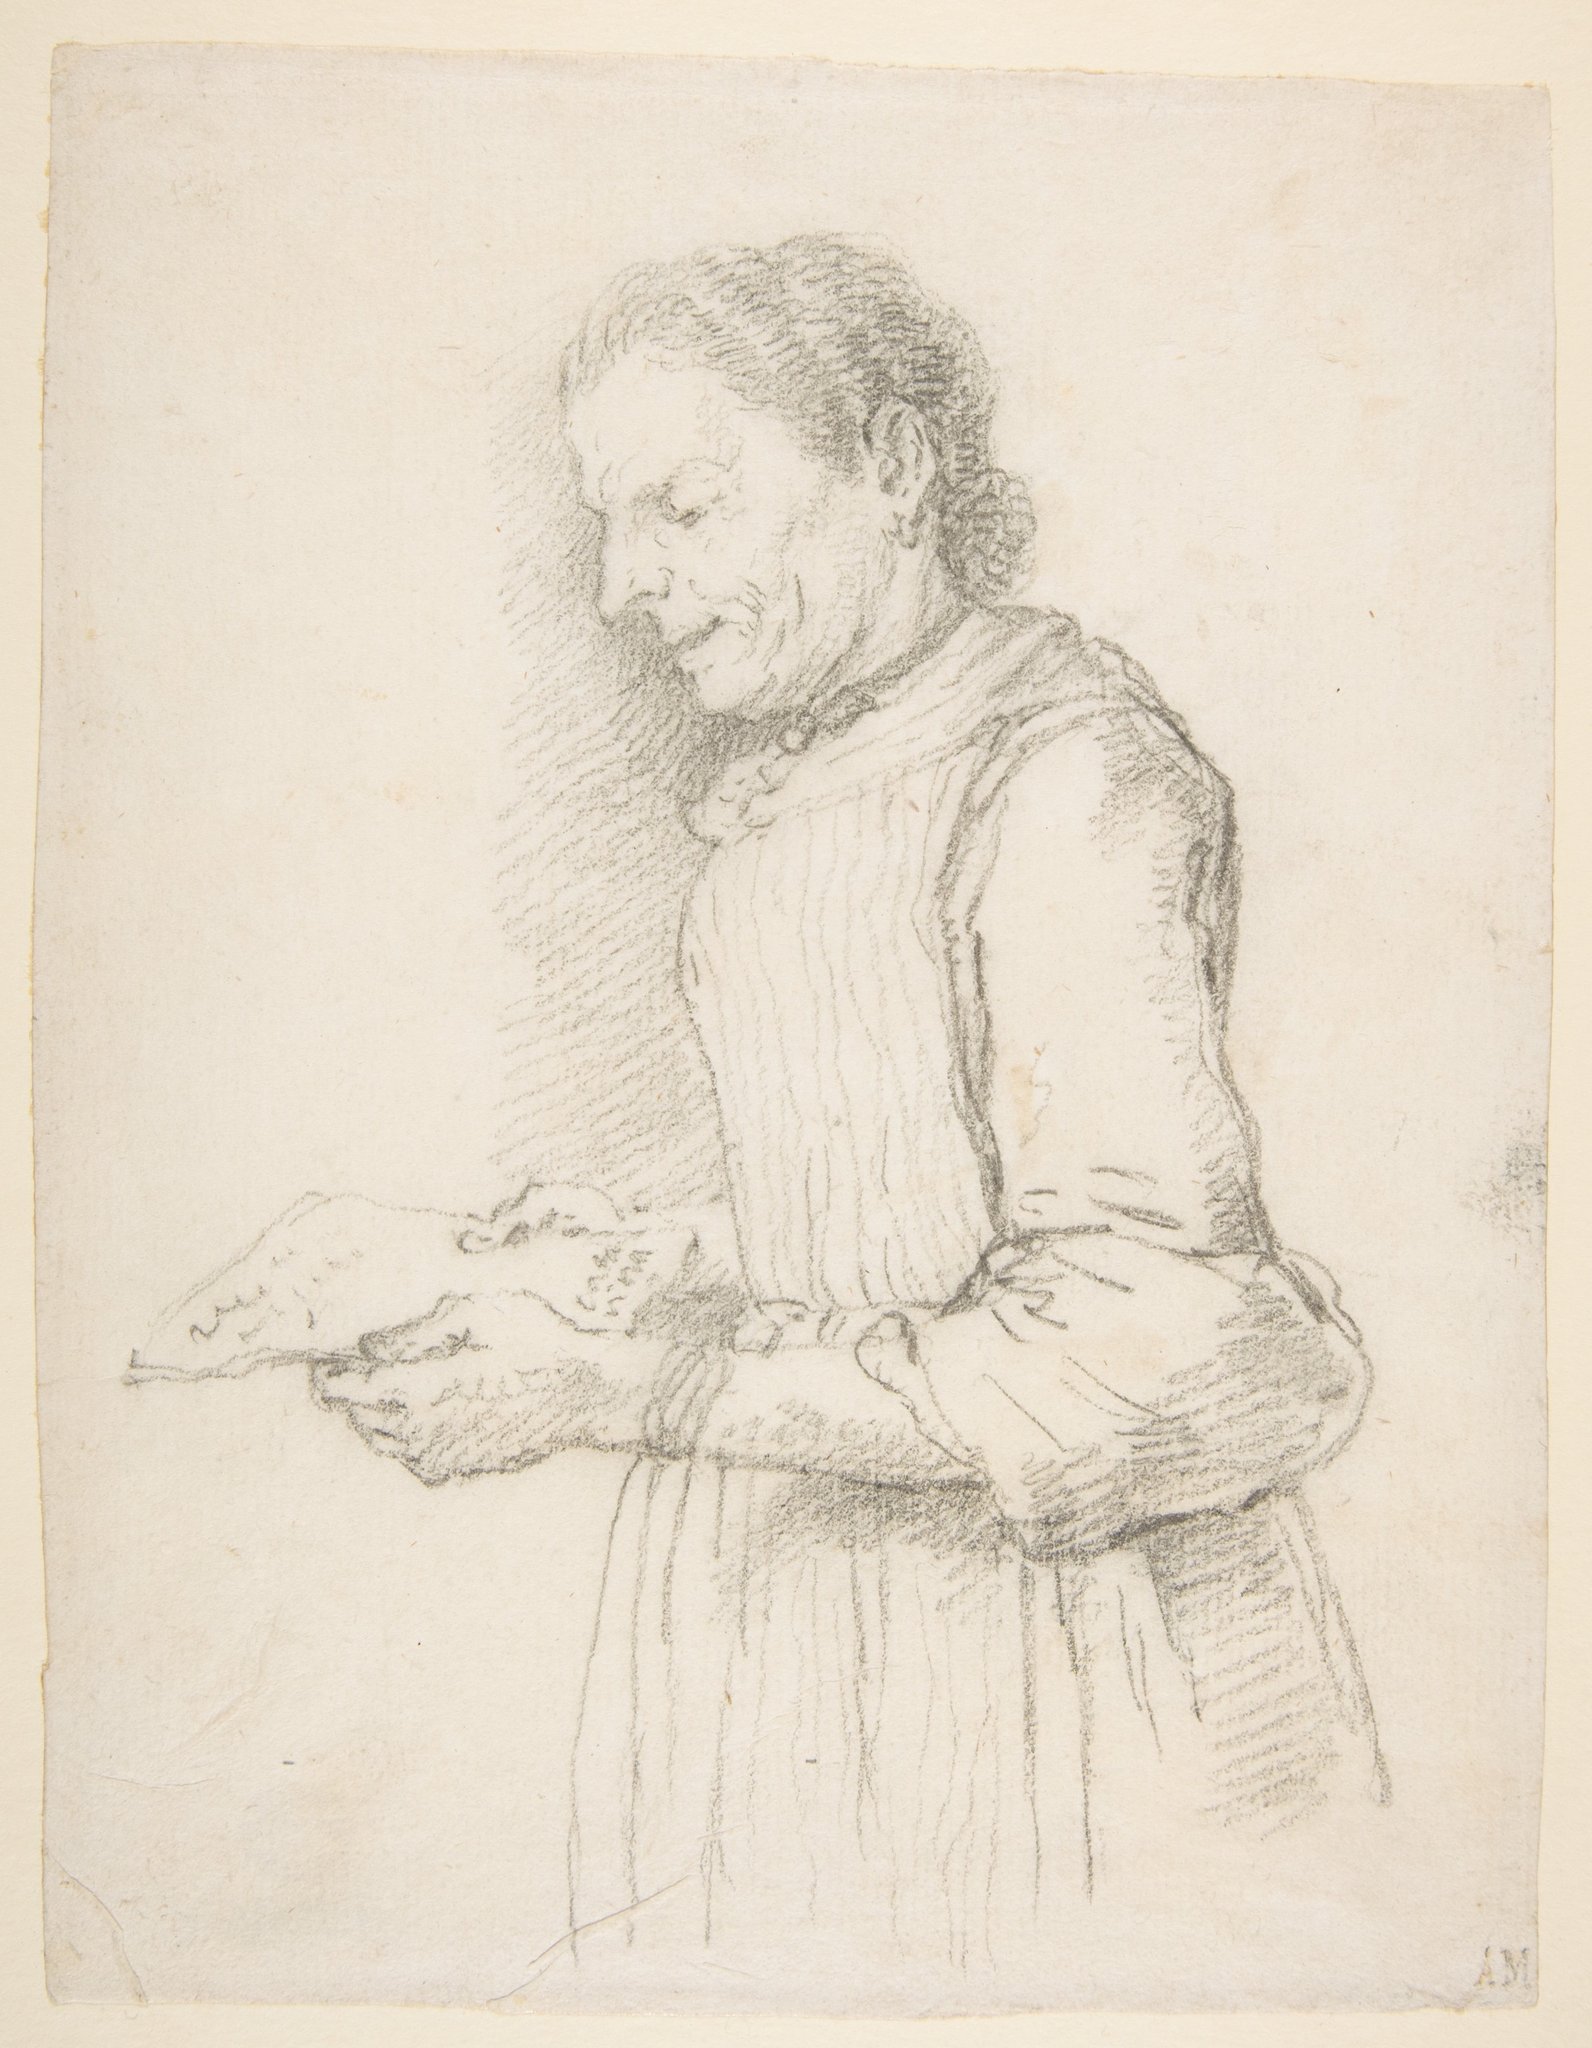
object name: drawing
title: Woman in Half-Length, Profile View Facing Left and Reading a Piece of Paper Signed "Catarina"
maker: francesco zuccarelli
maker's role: artist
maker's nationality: italian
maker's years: 1702-1788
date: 1702-1788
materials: chalk, graphite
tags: profiles,women,reading